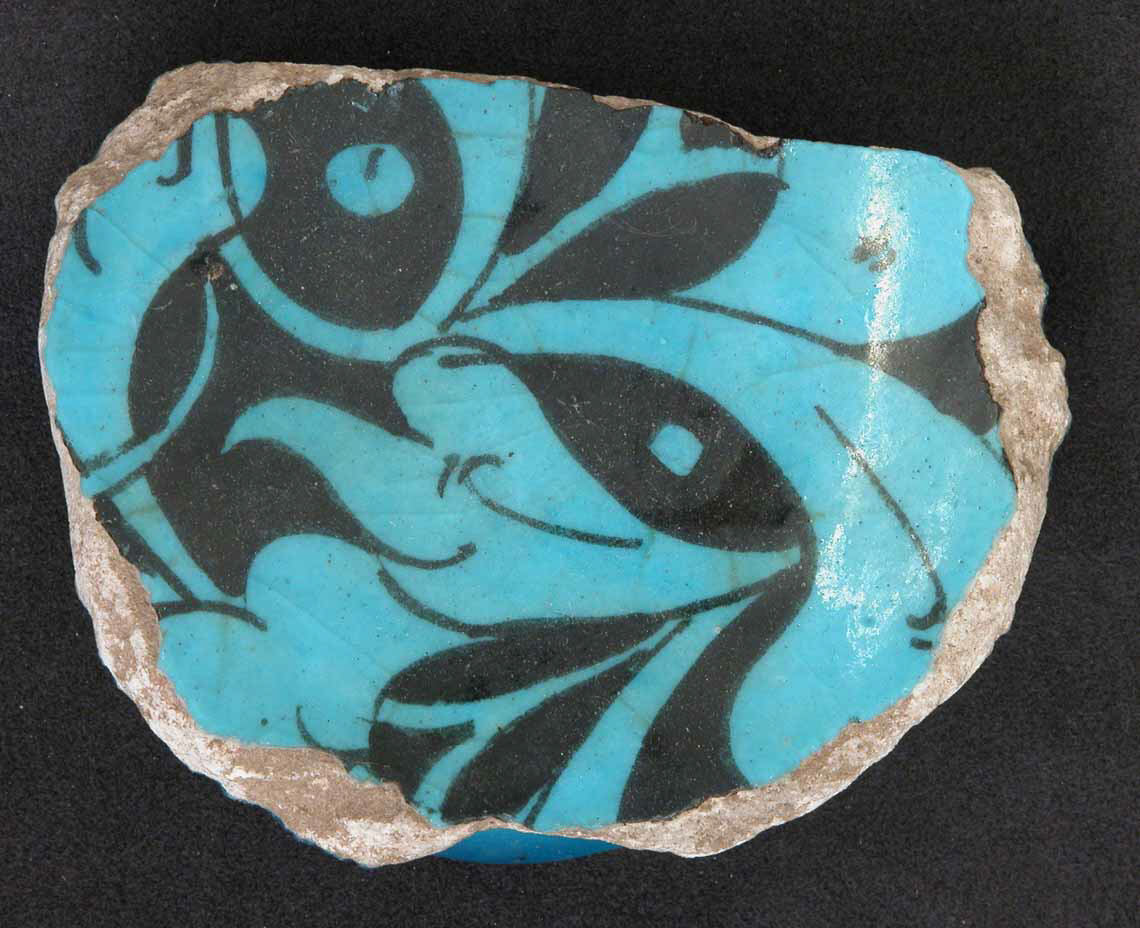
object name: ceramic fragment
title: Fragment of a Bowl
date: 1201-1300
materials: stonepaste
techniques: painting, underglaze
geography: syria